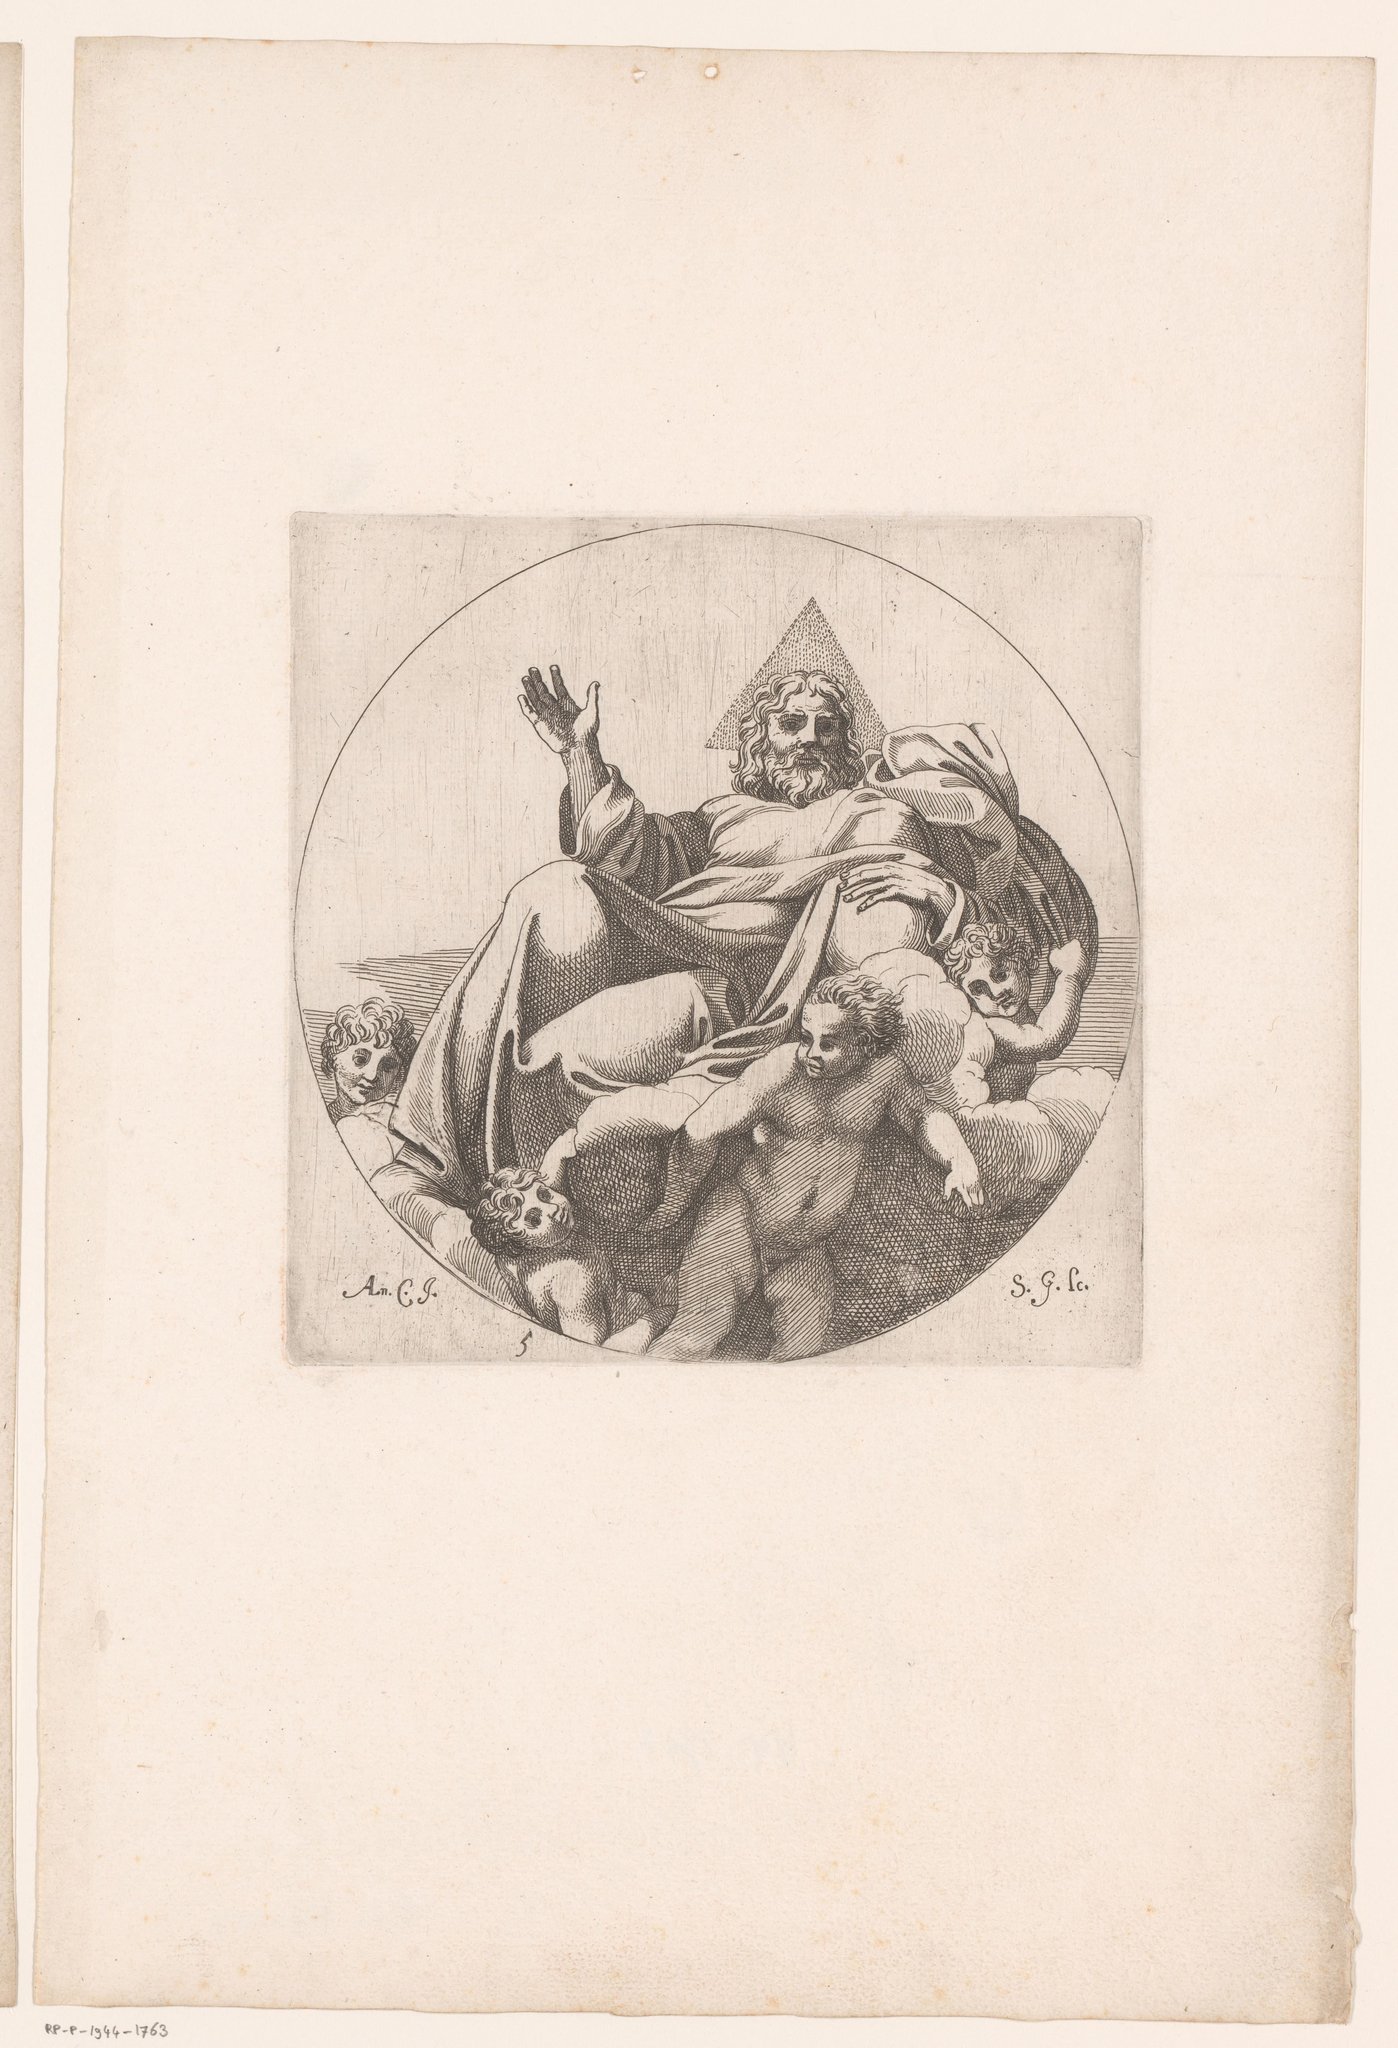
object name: print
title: God de Vader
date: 1646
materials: paper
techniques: etching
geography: rome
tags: god the father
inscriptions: collector's mark: Lugt 2228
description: Maakt deel uit van een twintigdelige serie getiteld 'Vita di San Diego dipinta nella Capella di S. Giacomo de Spagnoli a Roma' met scènes uit het leven van Juan Diego Cuauhtlatoatzin door Annibale Carracci in Herrera kapel van de Nostra Signora del Sacro Cuore te Rome. De serie werd in 1646 uitgegeven in Rome.